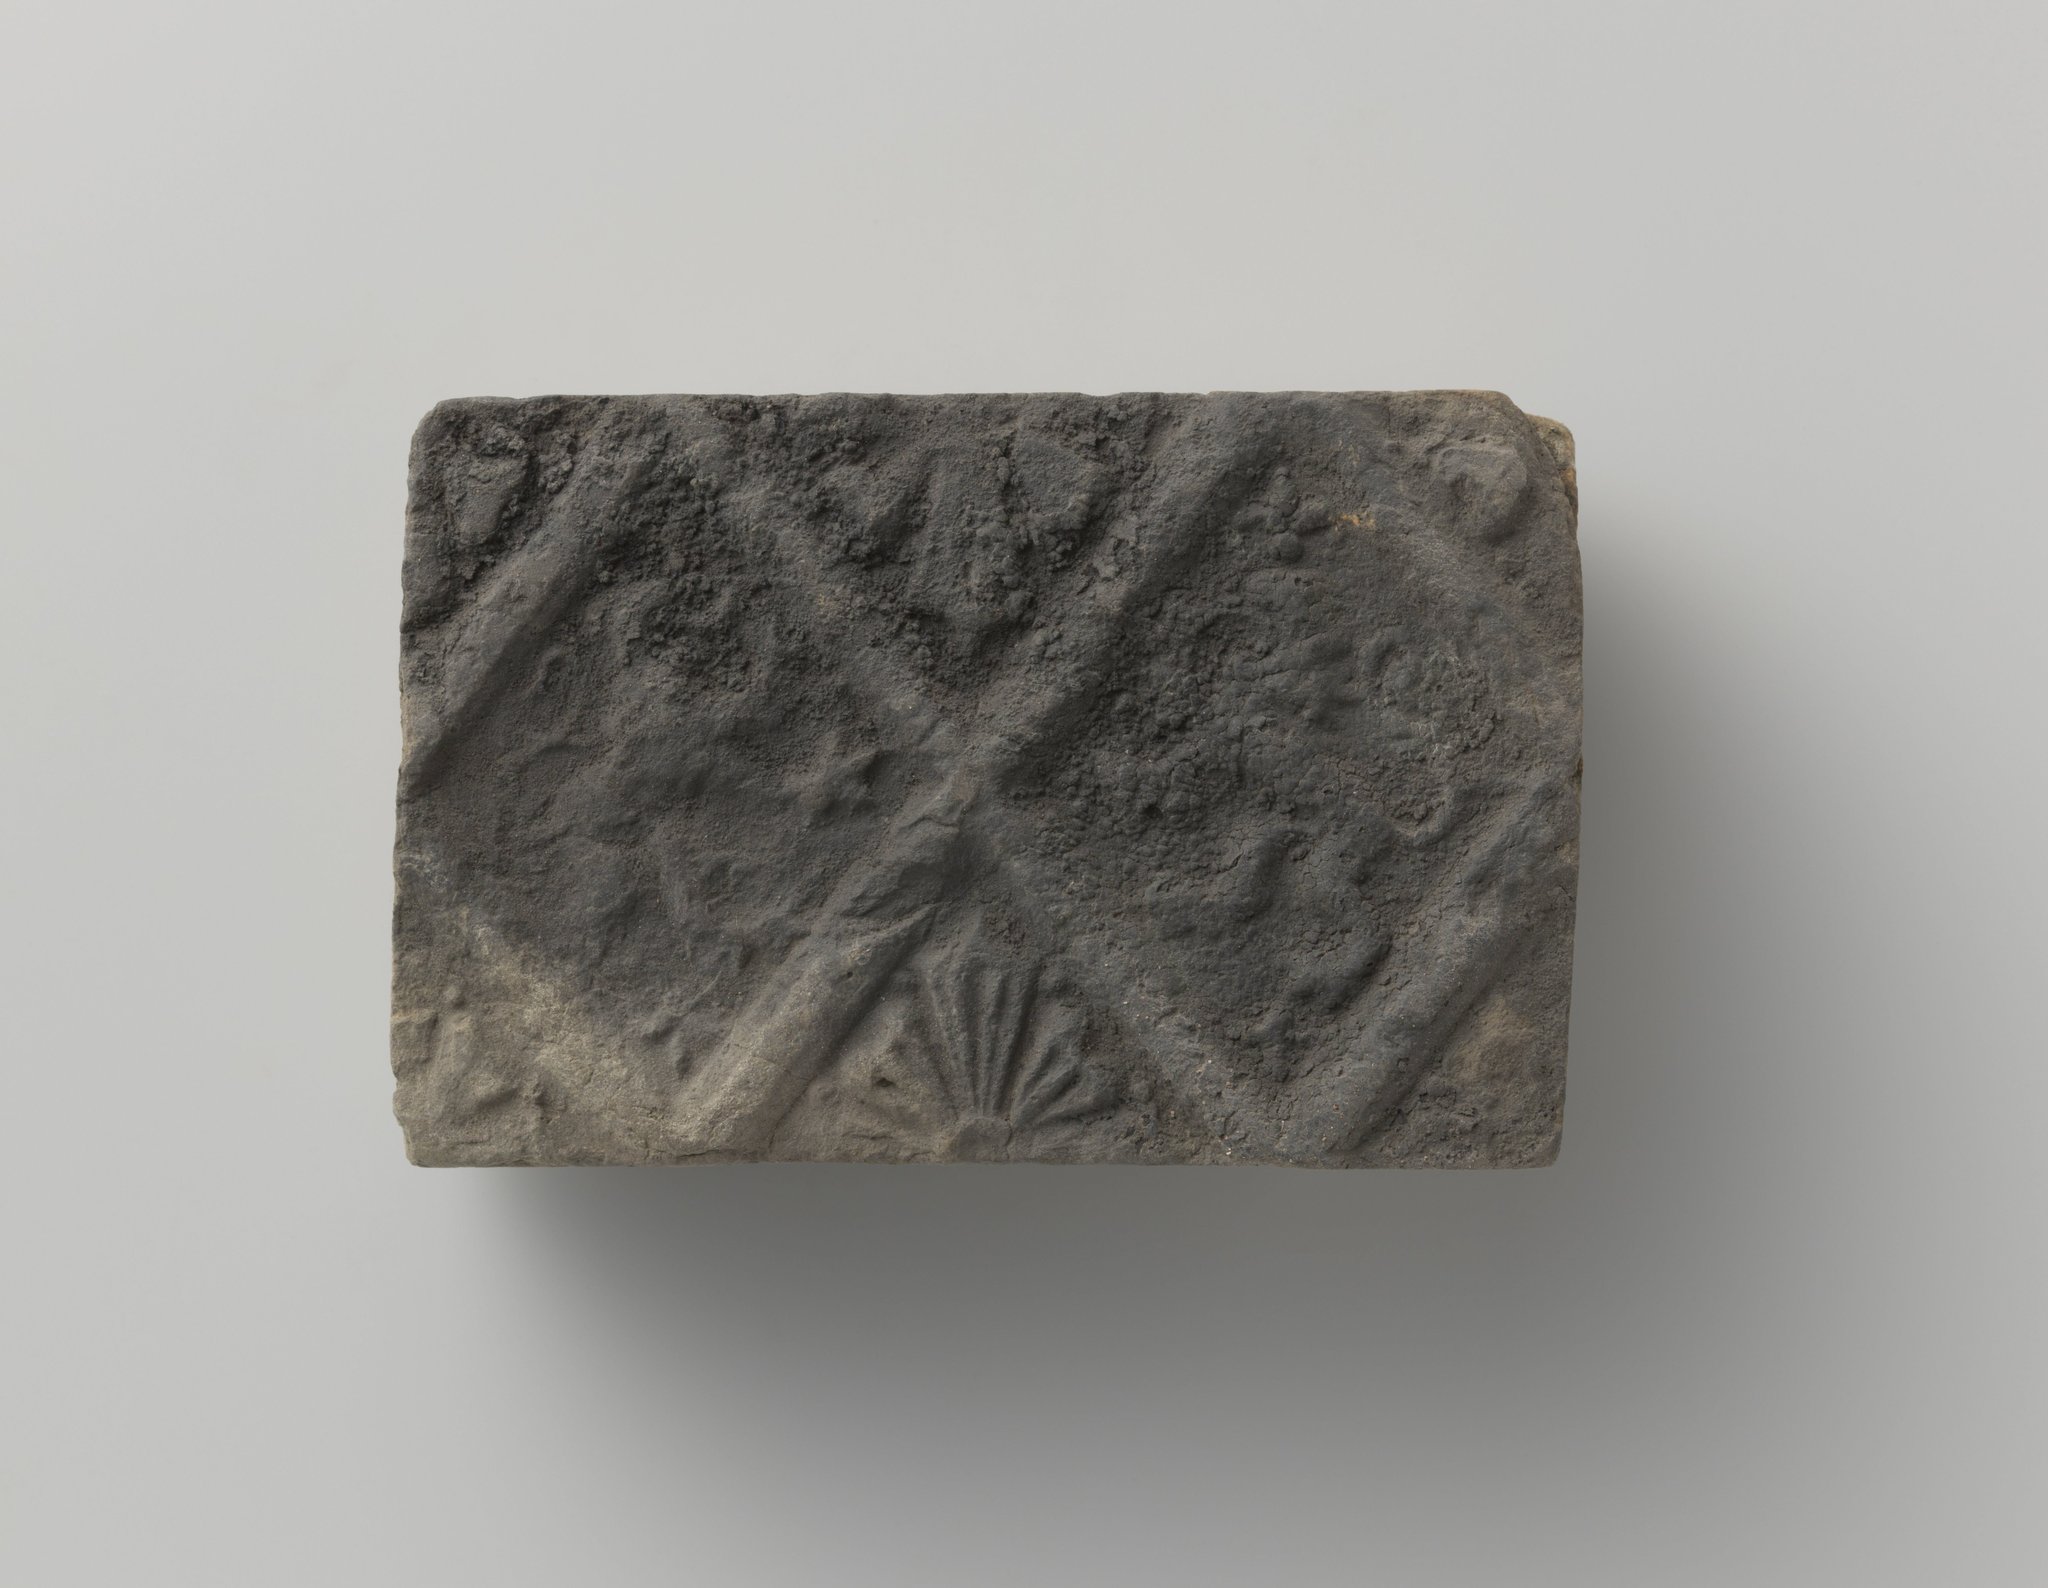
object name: hearthstone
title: Haardsteen met voorstelling van twee klimmende leeuwen, geplaatst in twee ruiten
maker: Anonymous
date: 1575-1625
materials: earthenware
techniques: printing, firing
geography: southern netherlands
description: Haardsteen met voorstelling van twee klimmende leeuwen, geplaatst in twee ruiten.